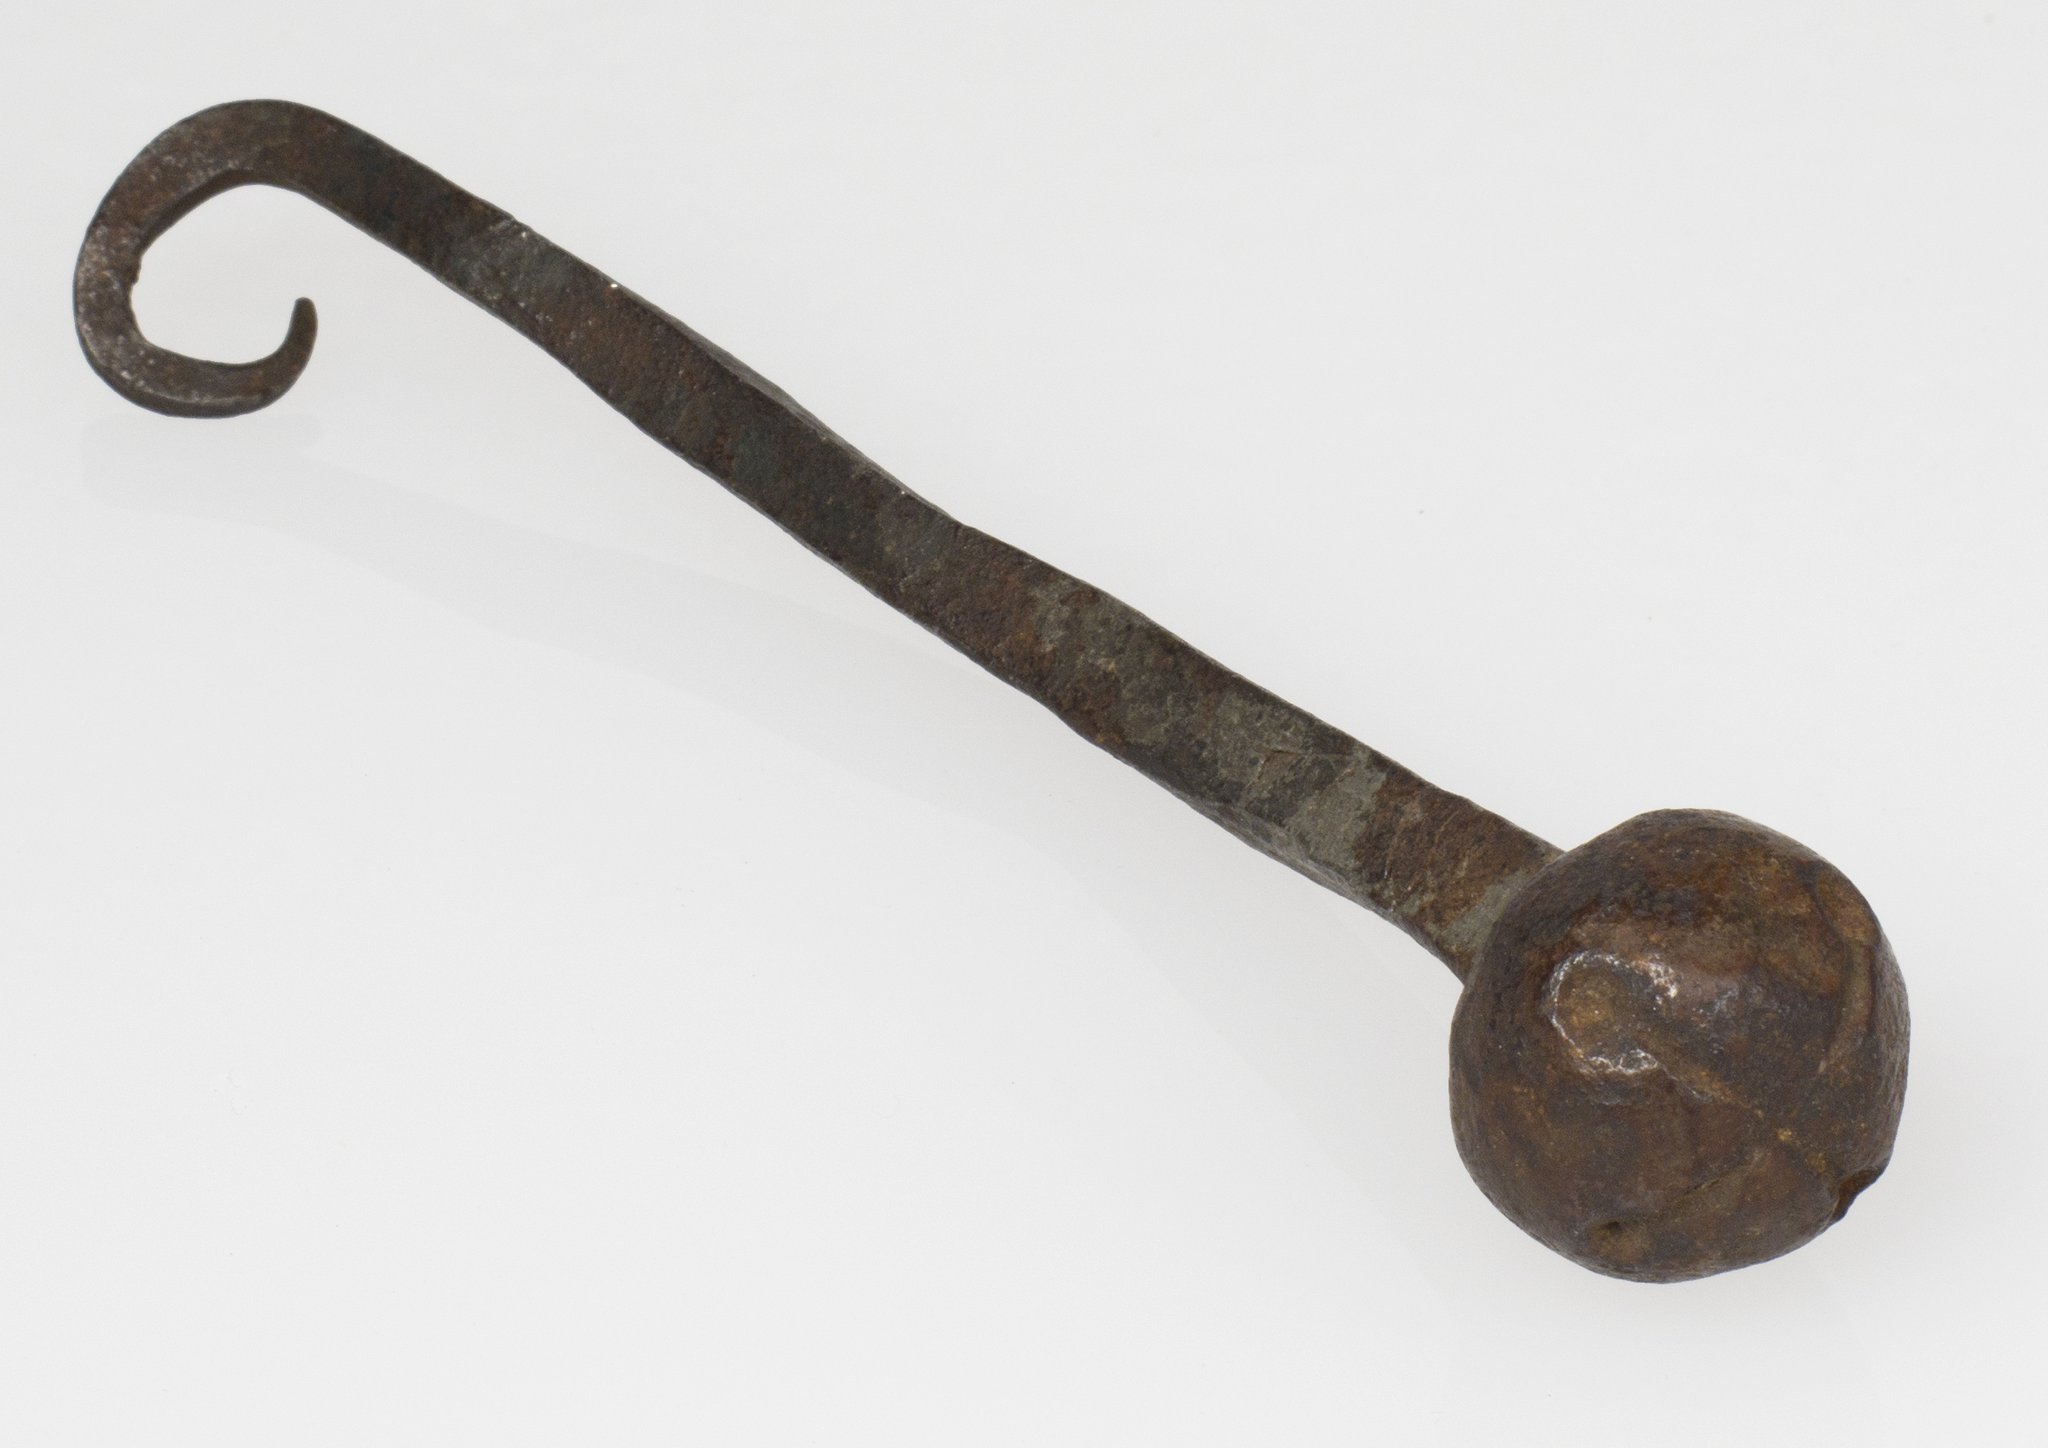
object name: nail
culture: european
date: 1401-1600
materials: iron